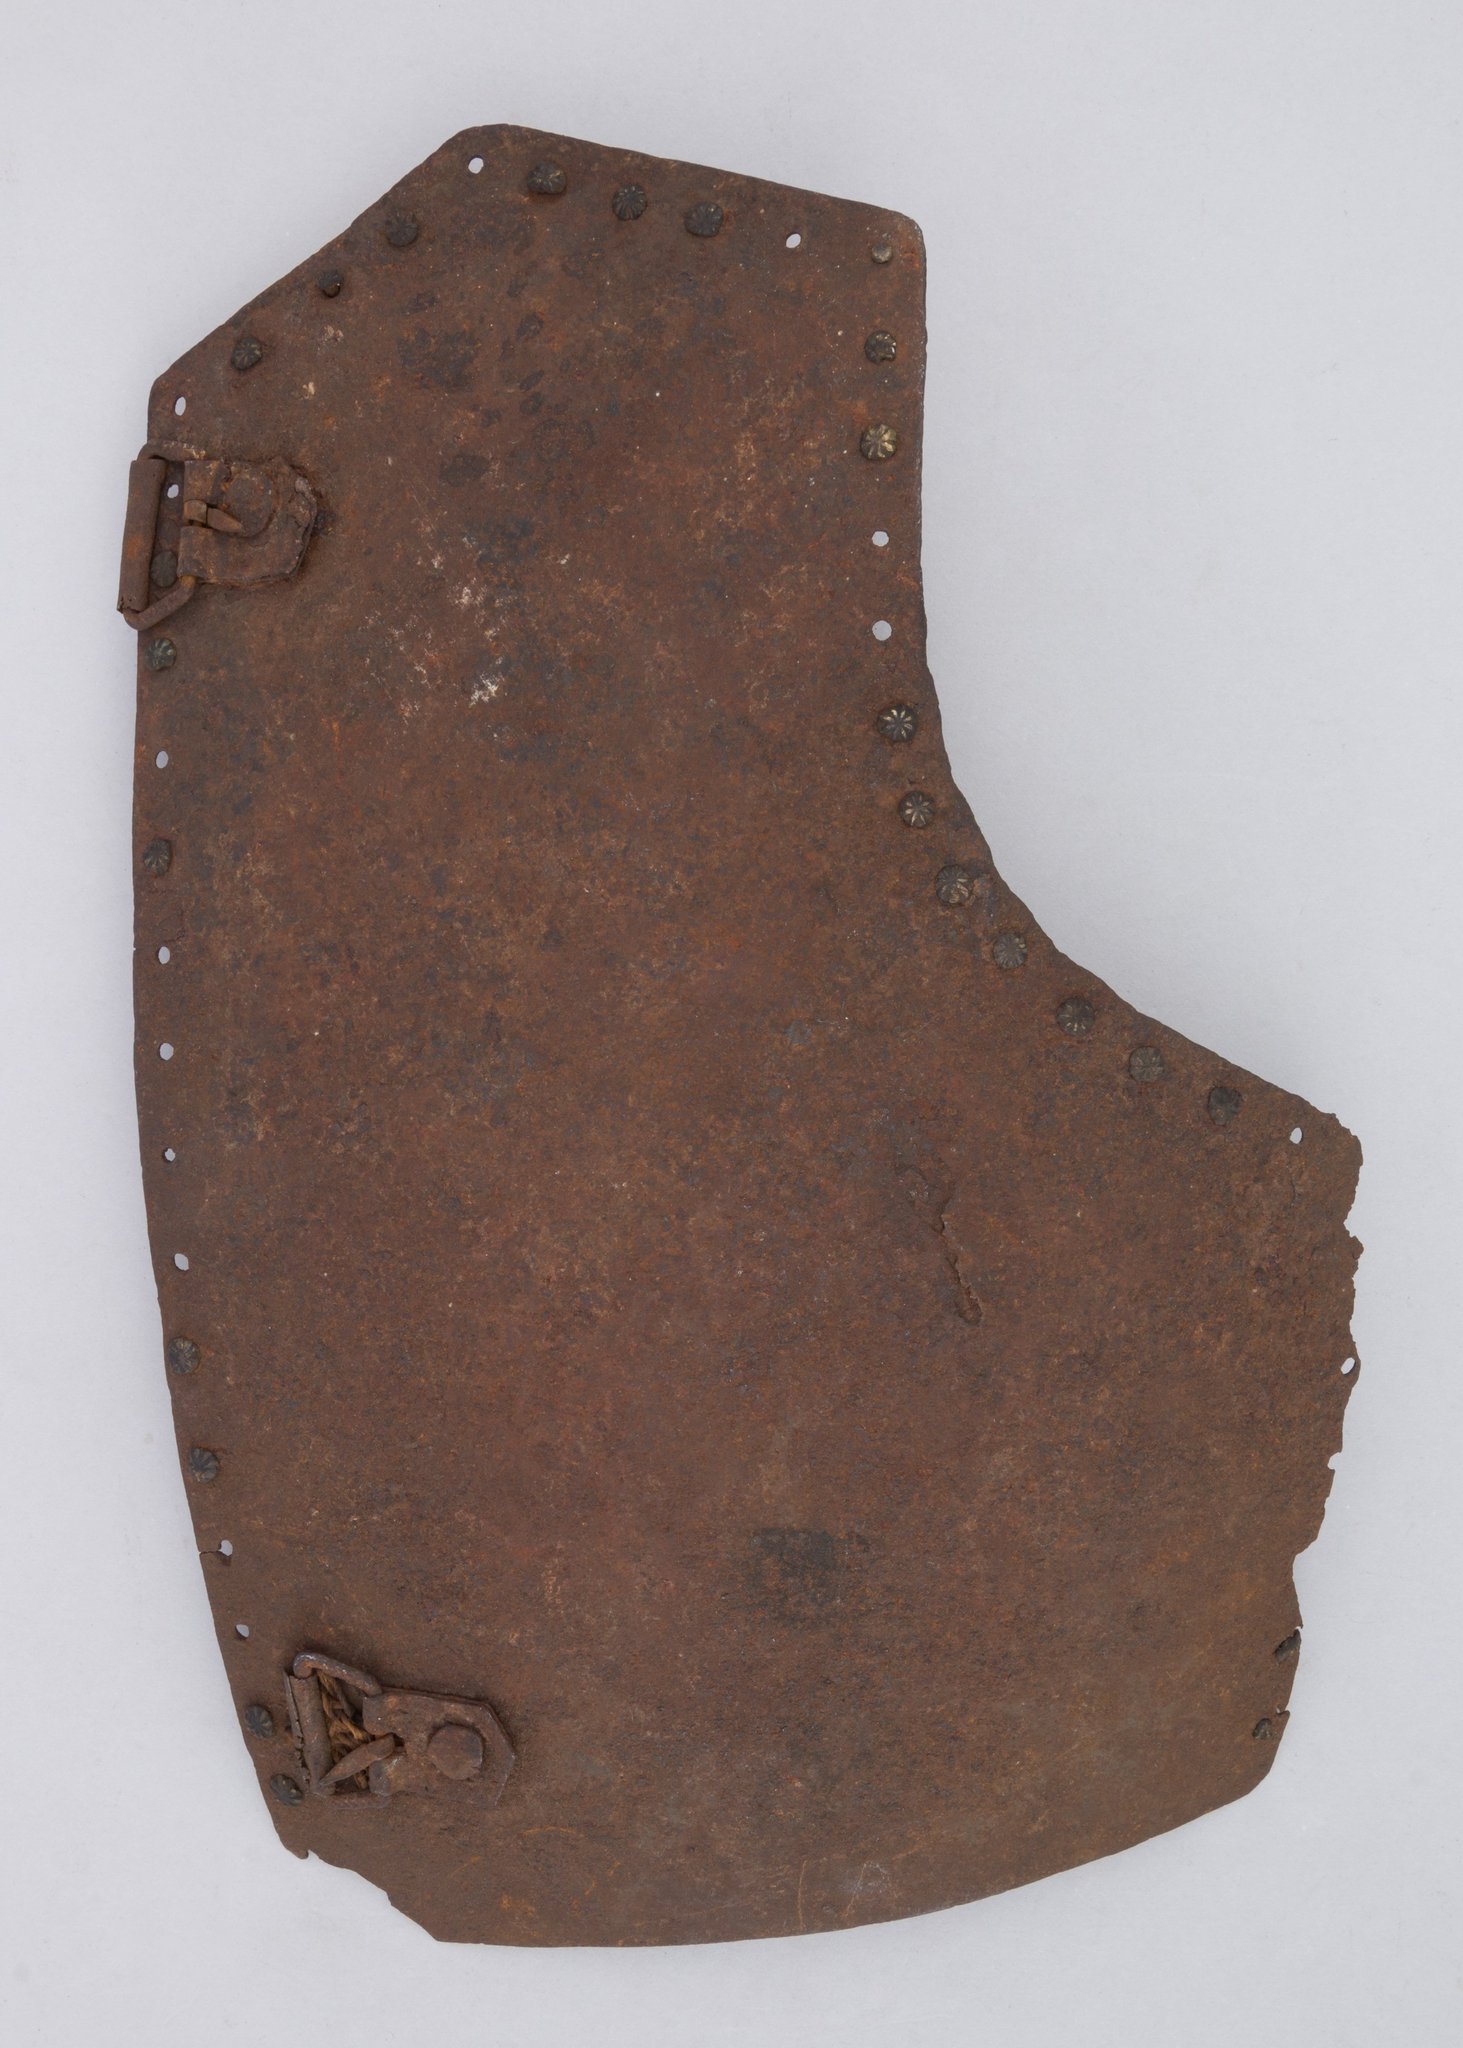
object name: brigandine plate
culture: italian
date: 1400-1450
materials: copper alloy, metal alloy, textile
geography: italy